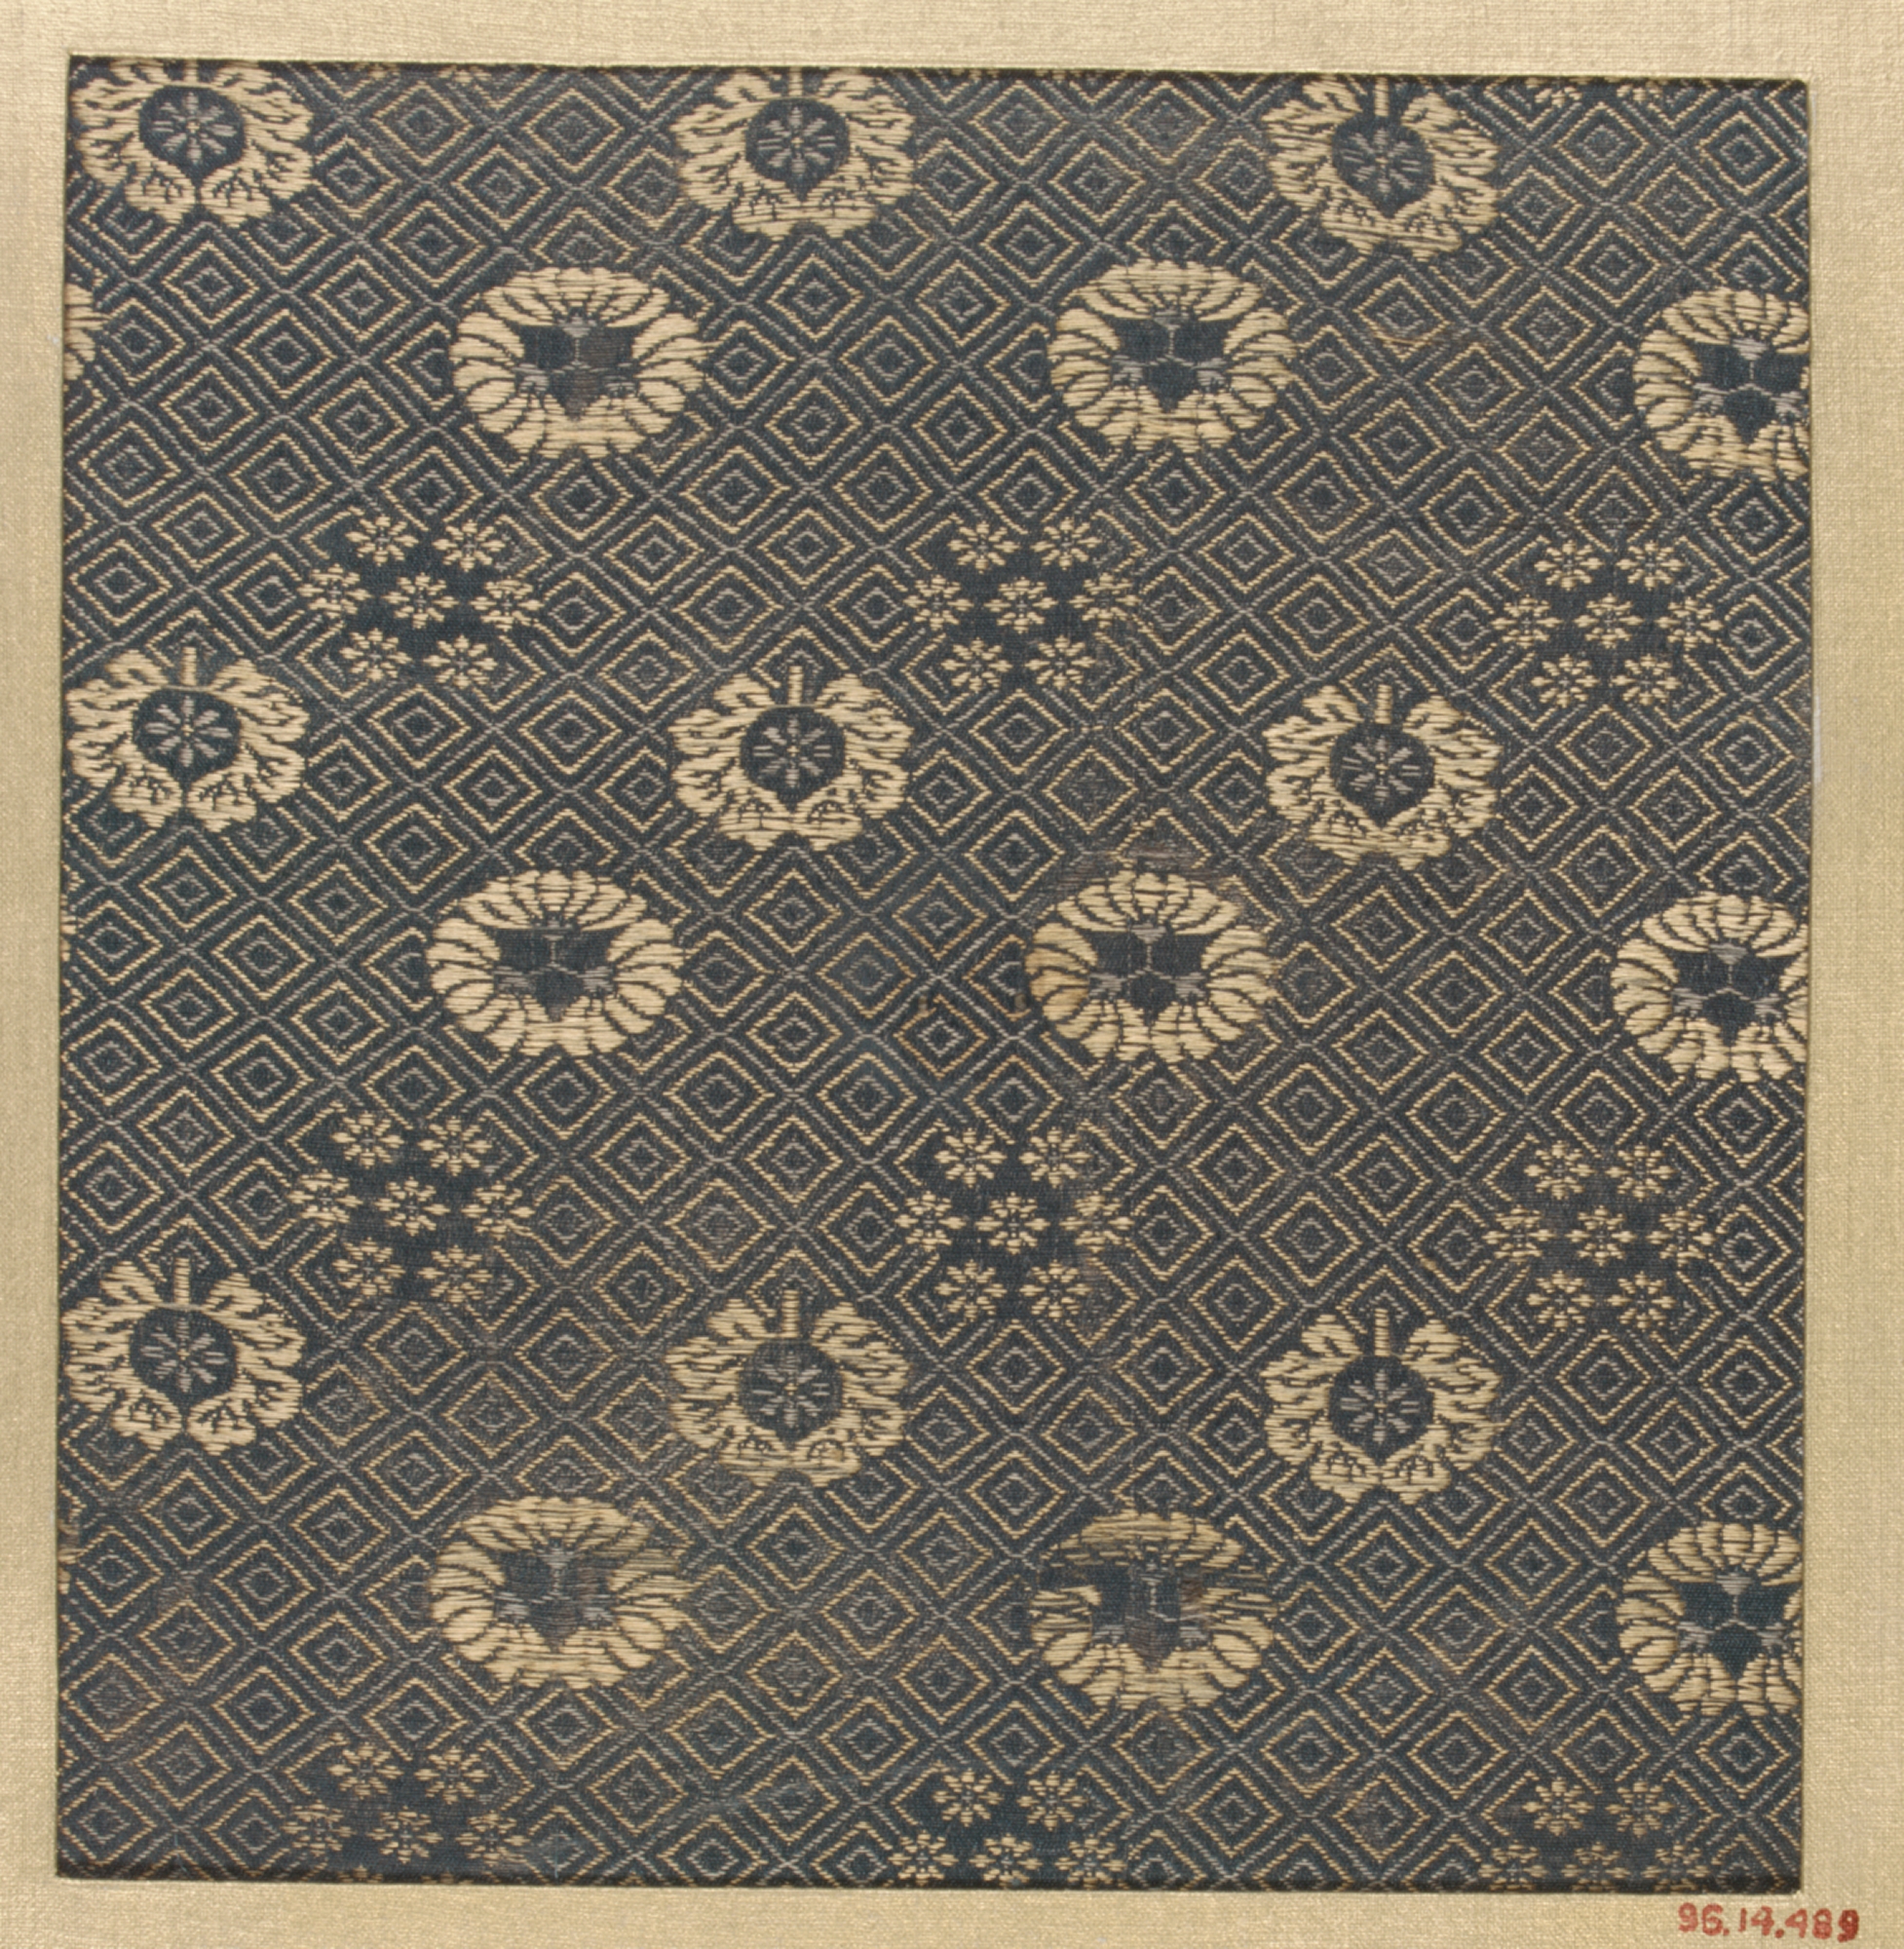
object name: piece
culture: japanese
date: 1701-1900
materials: silk